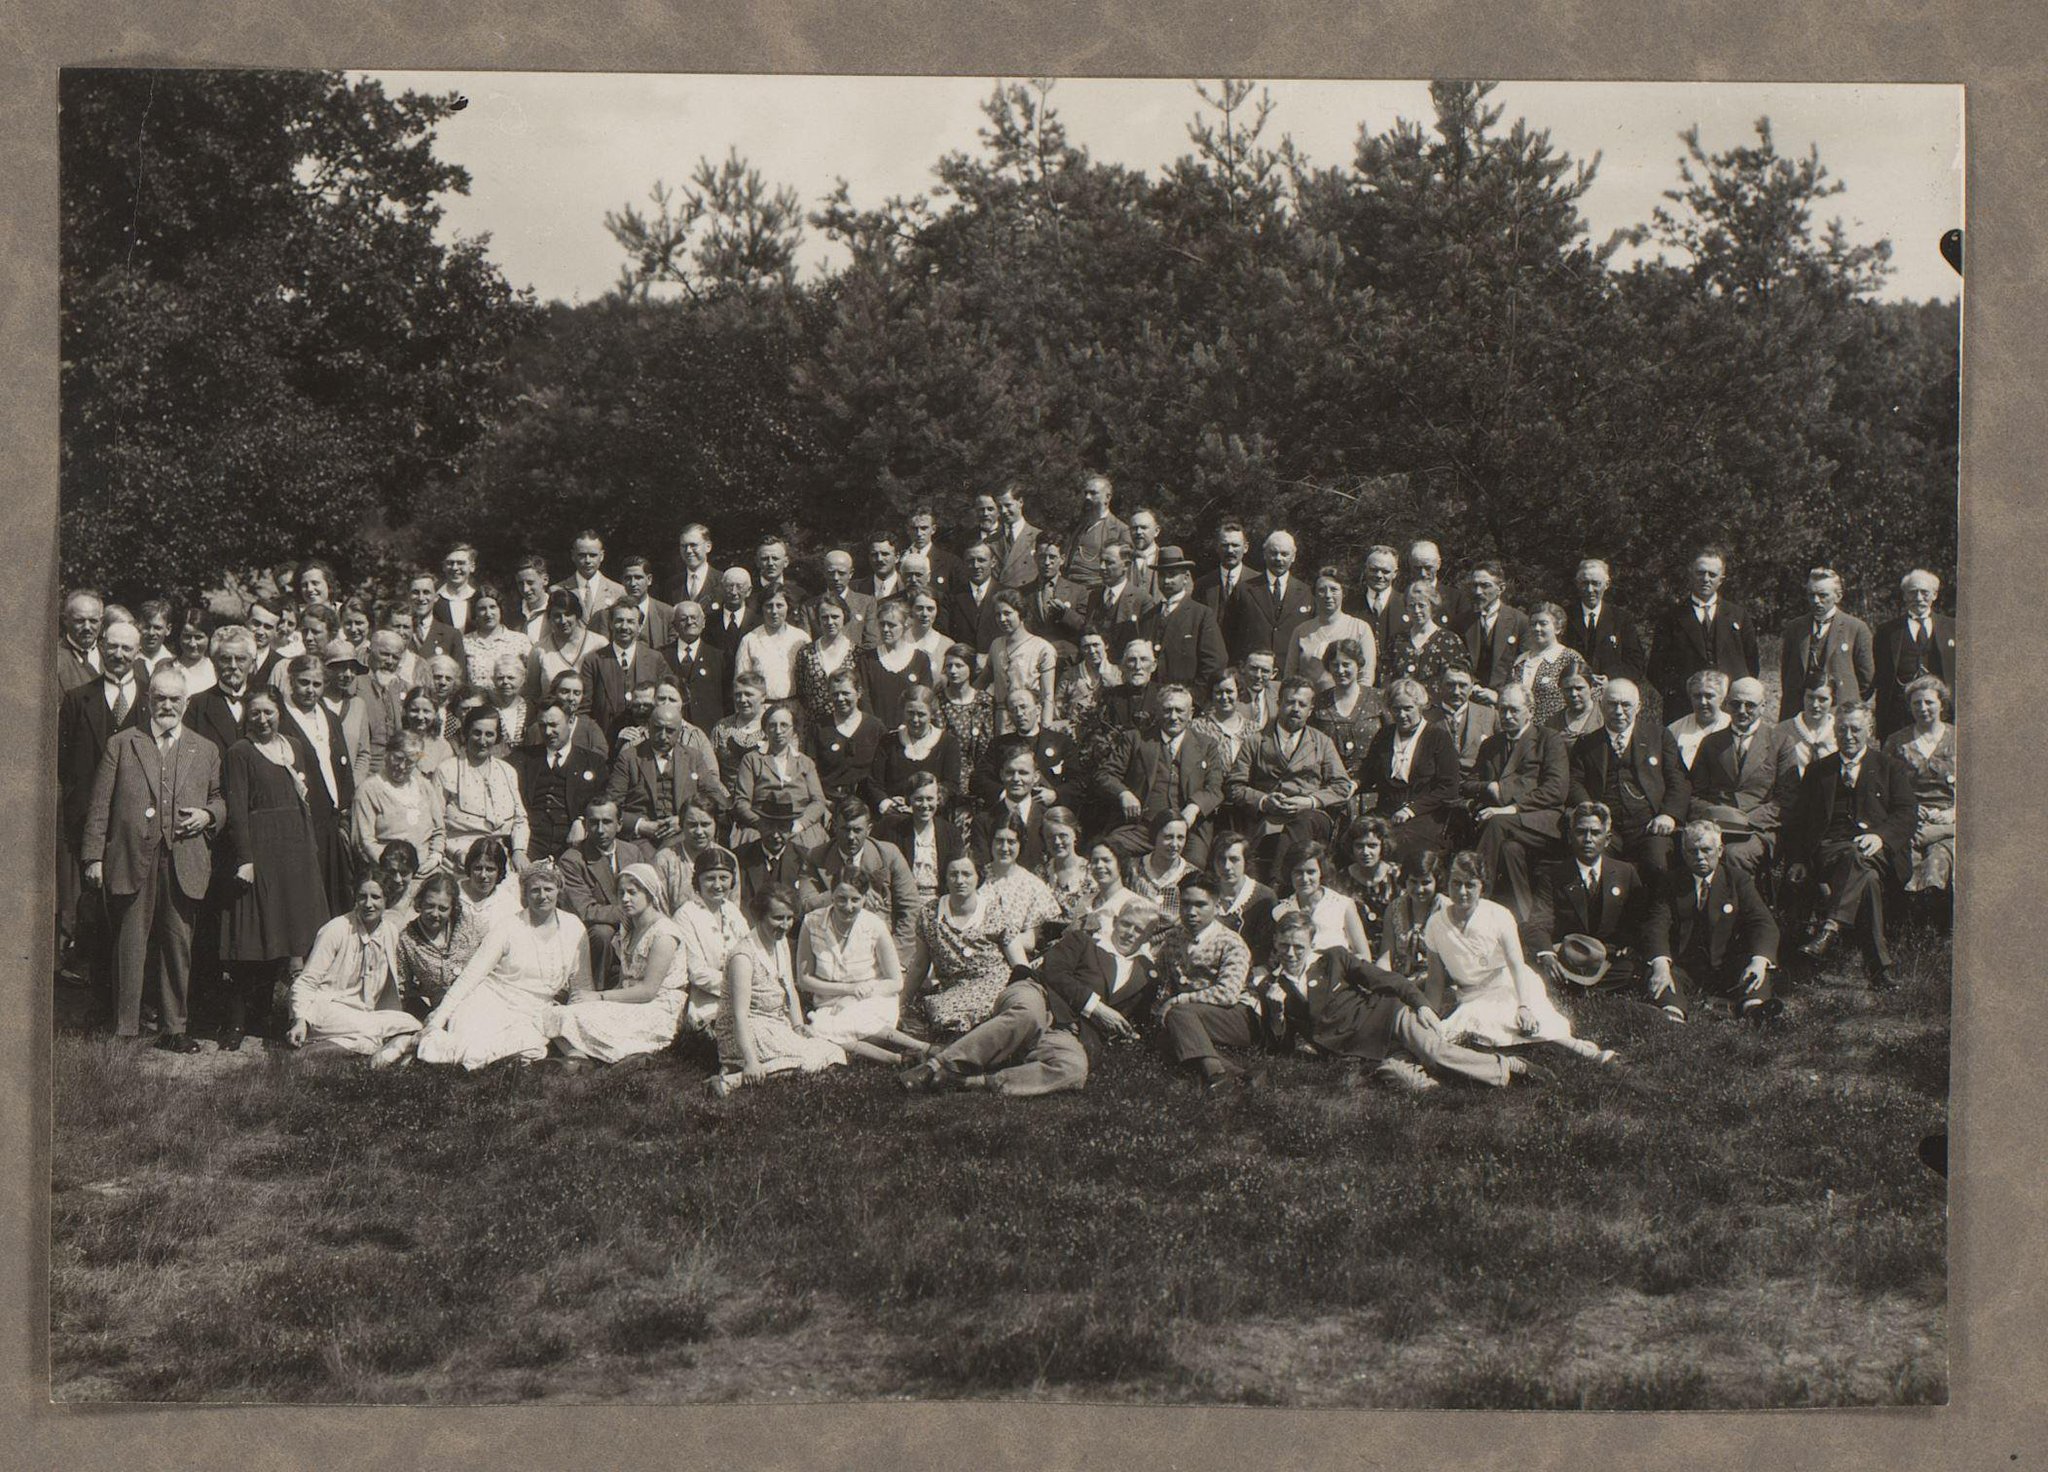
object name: album leaf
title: Groepsportret van een gezelschap op de Lunterse Zendingsconferentie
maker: Anonymous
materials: paper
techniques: gelatin silver print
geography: lunteren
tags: anonymous historical persons portrayed in a group, in a group-portrait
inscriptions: inscription: ‘1931. Lunteren/ 40 Zendingsconferentie/ 15-22 Aug/ voorzitter Dr J. van Nes’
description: Deze foto zit los achterin het fotoalbum.